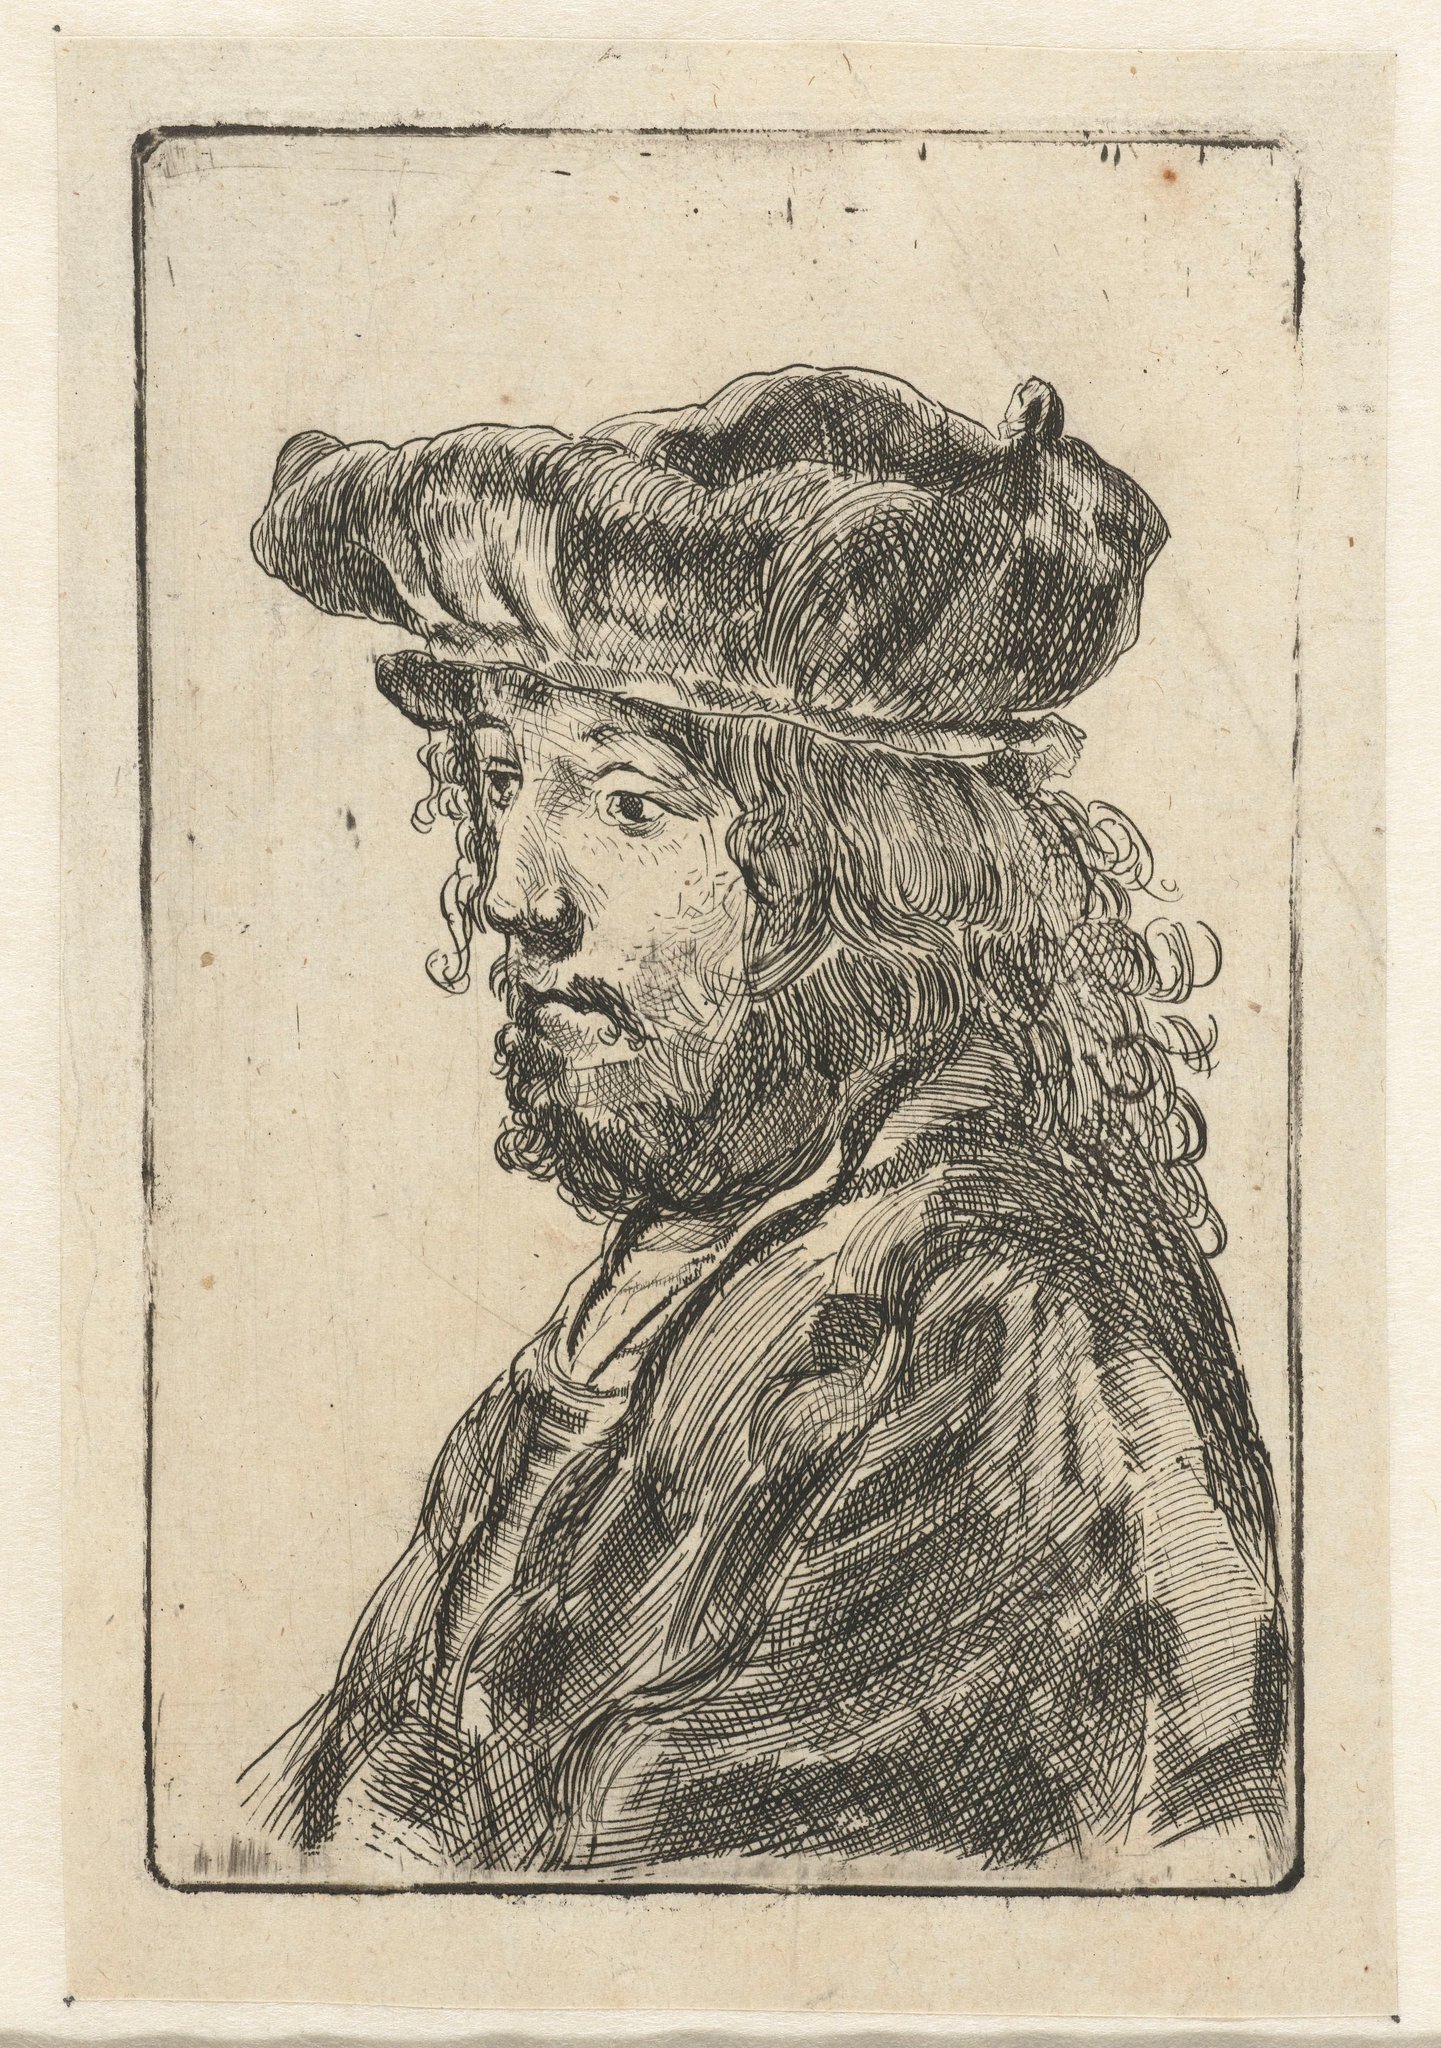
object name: print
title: The fourth oriental head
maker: Anonymous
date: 1635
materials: paper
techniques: etching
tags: youth, adolescent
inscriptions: collector's mark: Lugt 2760, collector's mark: Lugt 2228